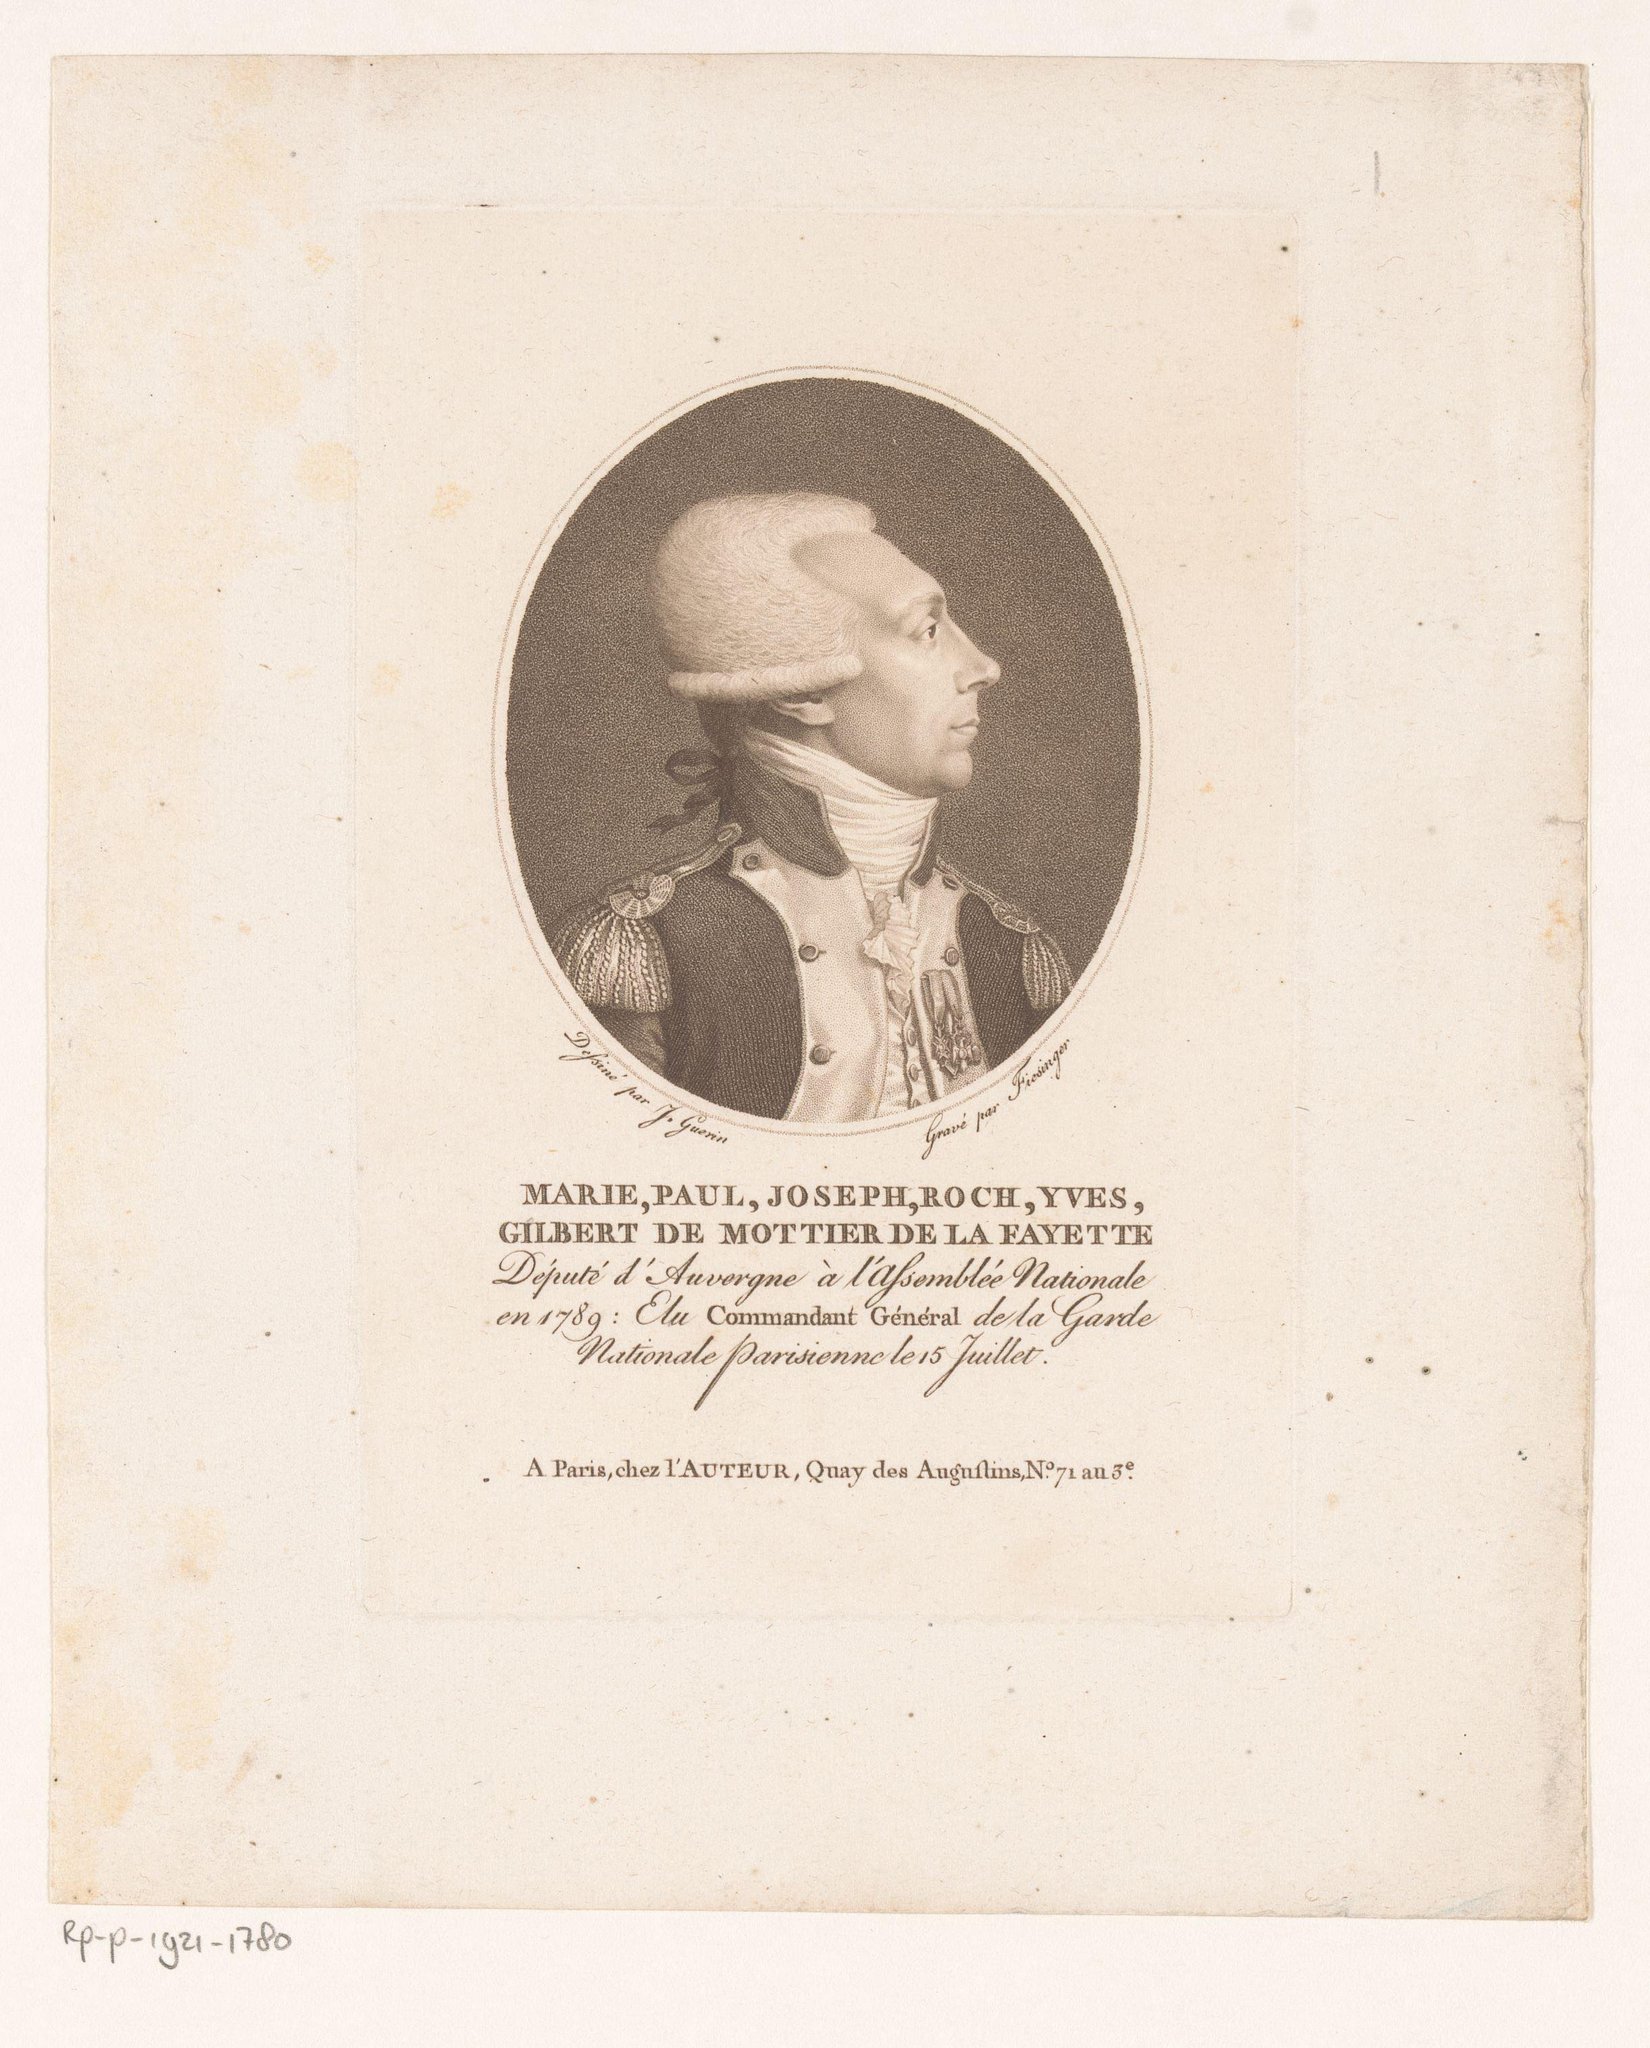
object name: print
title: Portret van Gilbert du Motier de la Fayette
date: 1789-1807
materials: paper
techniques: stippling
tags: paris, politician, historical persons, medals and other marks of military honour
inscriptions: collector's mark: Lugt 2233